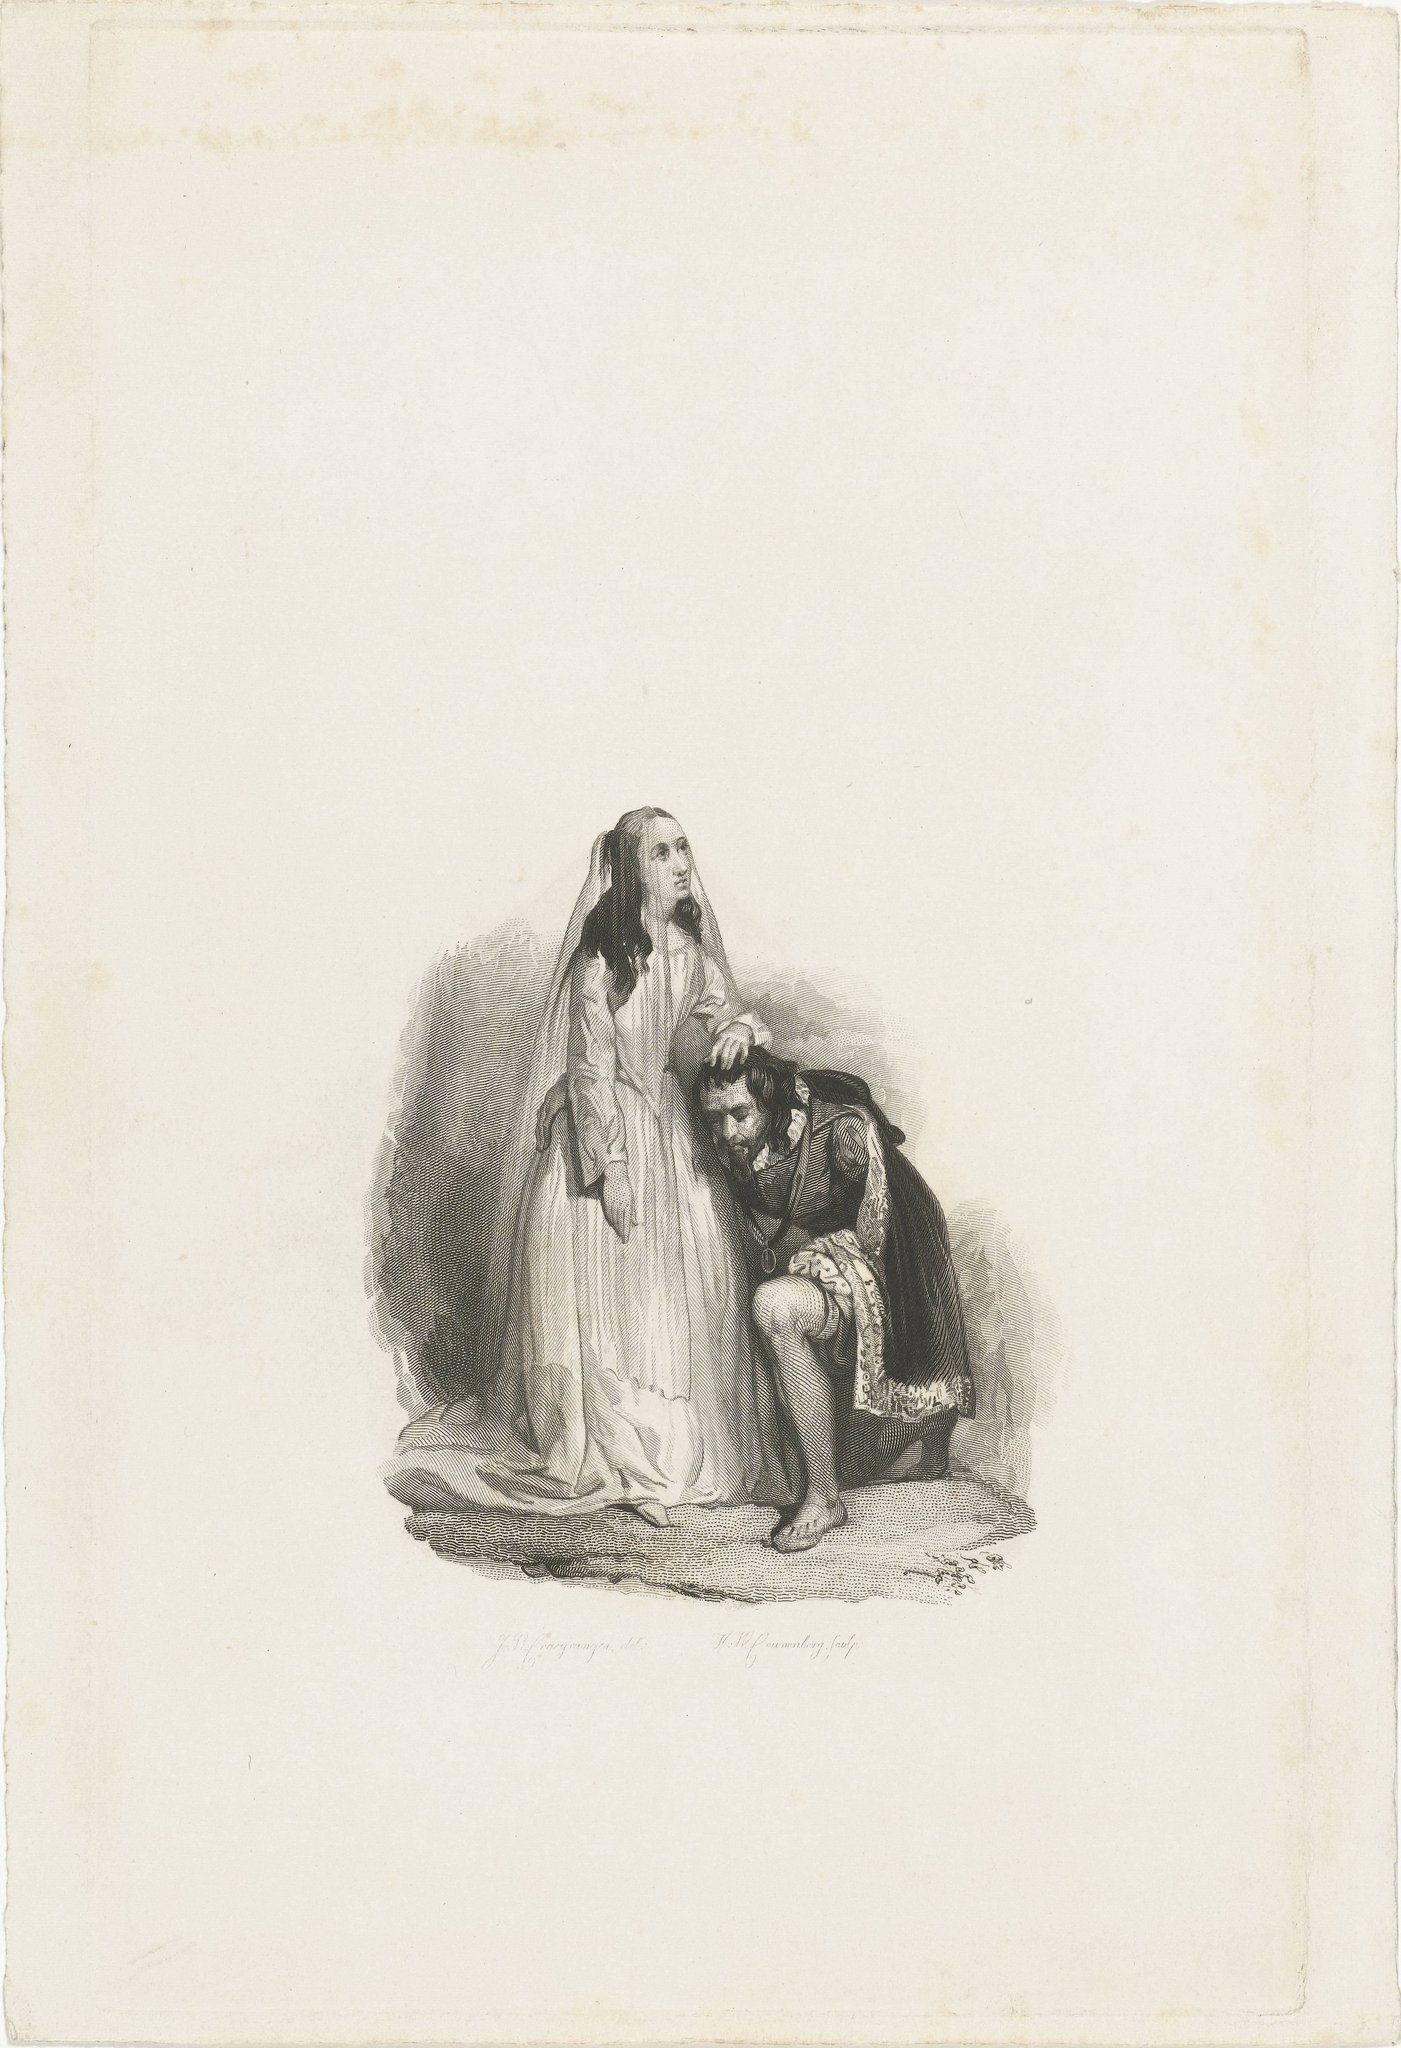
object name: book illustration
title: Jose knielt neer voor Florinde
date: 1838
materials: paper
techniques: engraving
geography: amsterdam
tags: hidden love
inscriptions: collector's mark: Lugt 2228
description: Titelpagina voor: Nicolaas Beets, Jose. Een verhaal. Amsterdam: J. Immerzeel jr., 1838.